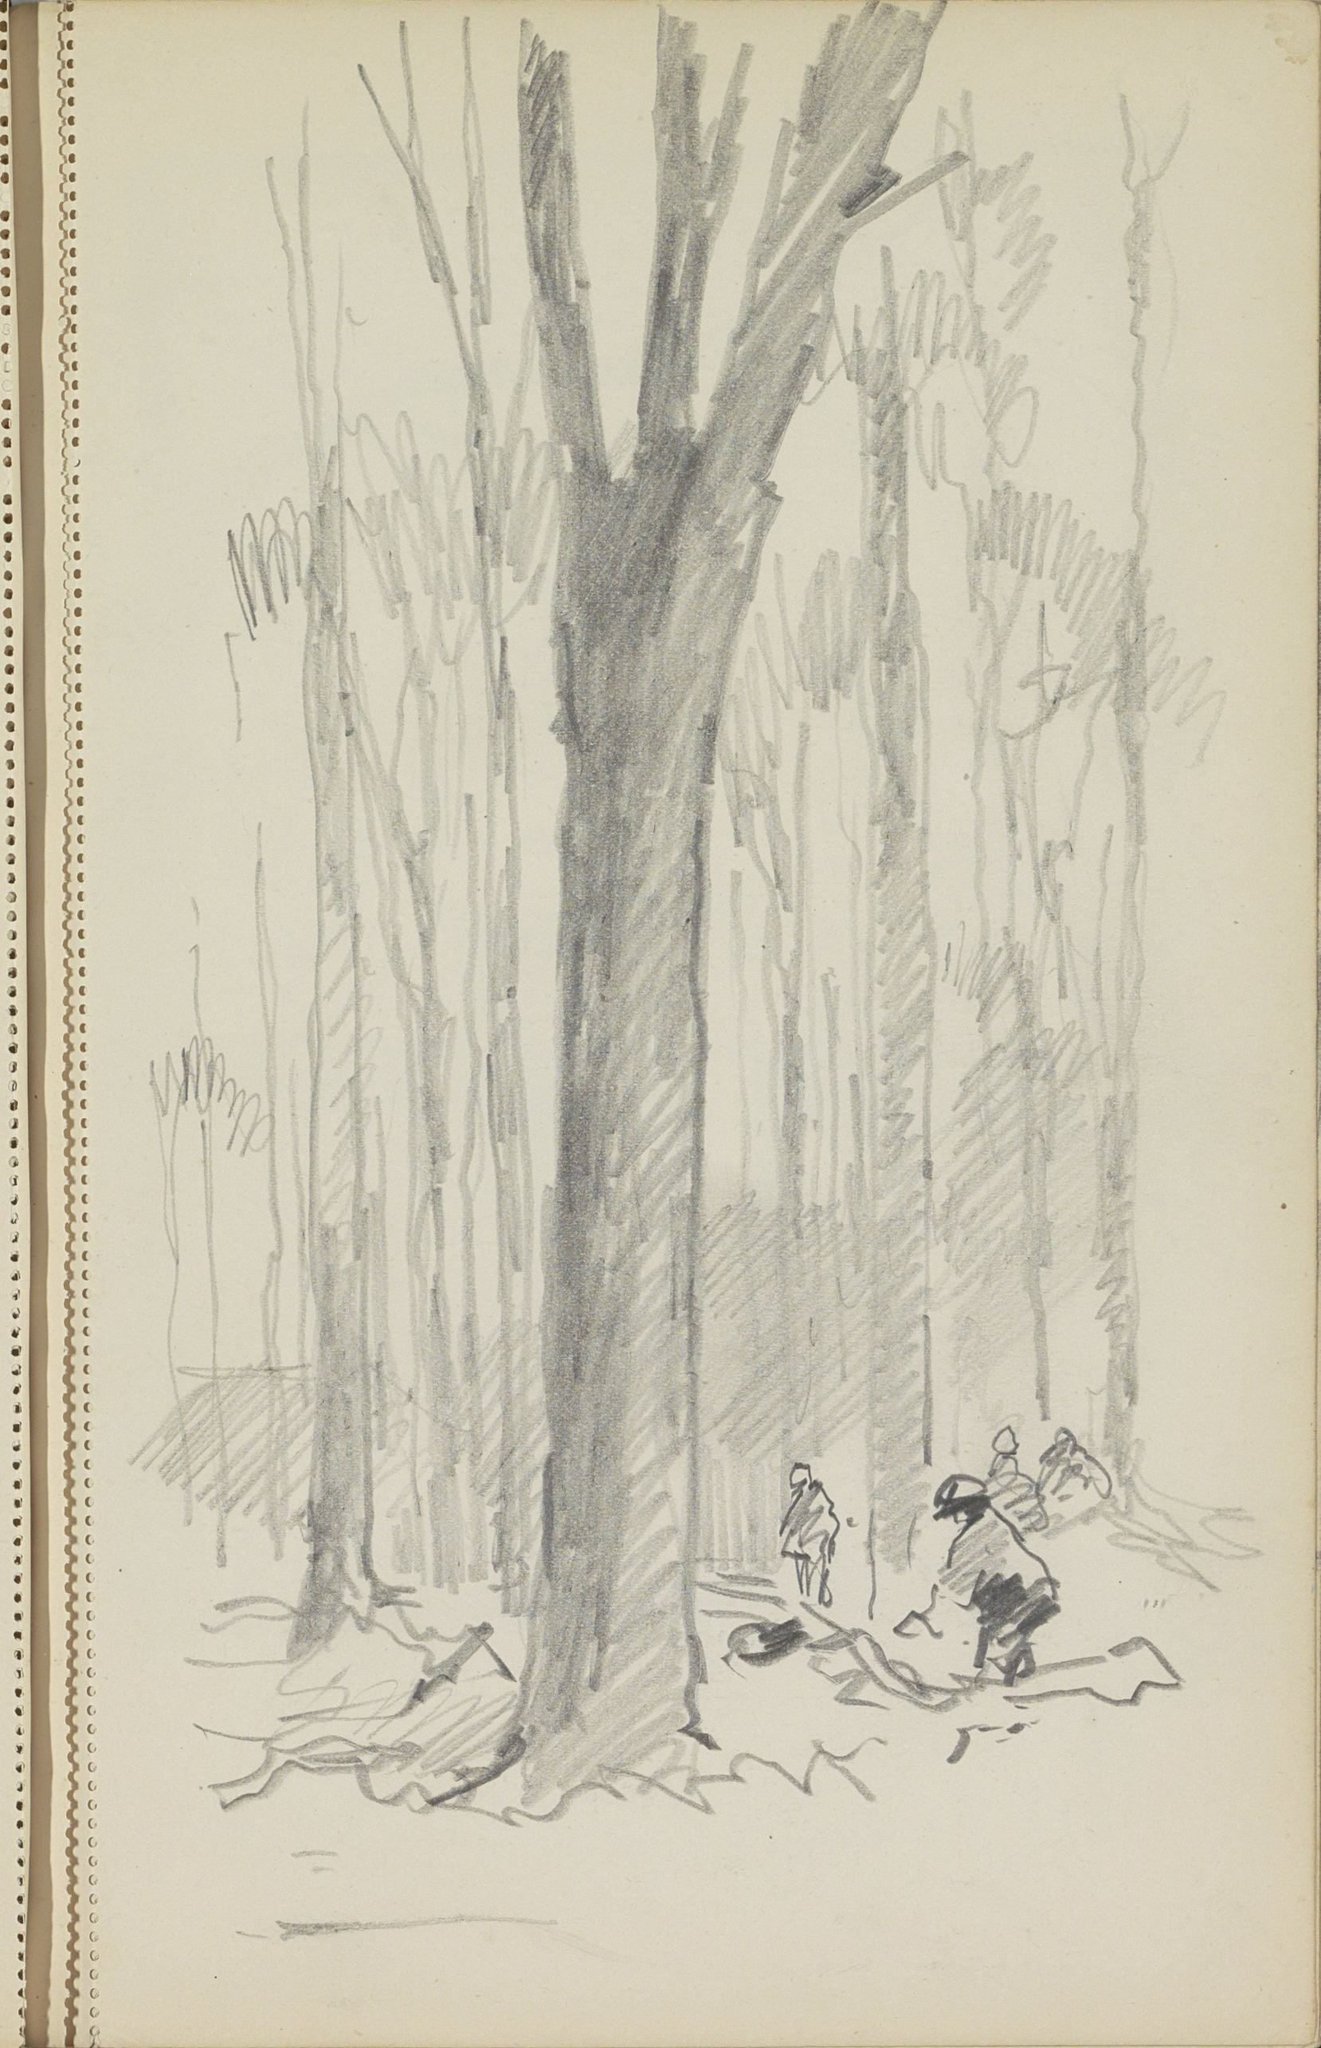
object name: sketchbook leaf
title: Figuren in een bos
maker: cornelis vreedenburgh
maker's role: draughtsman, print maker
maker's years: 1880-1946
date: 1890-1946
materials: paper, pencil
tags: forest, wood (+ landscape with figures, staffage)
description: Blad 44 recto uit een schetsboek met 56 bladen.